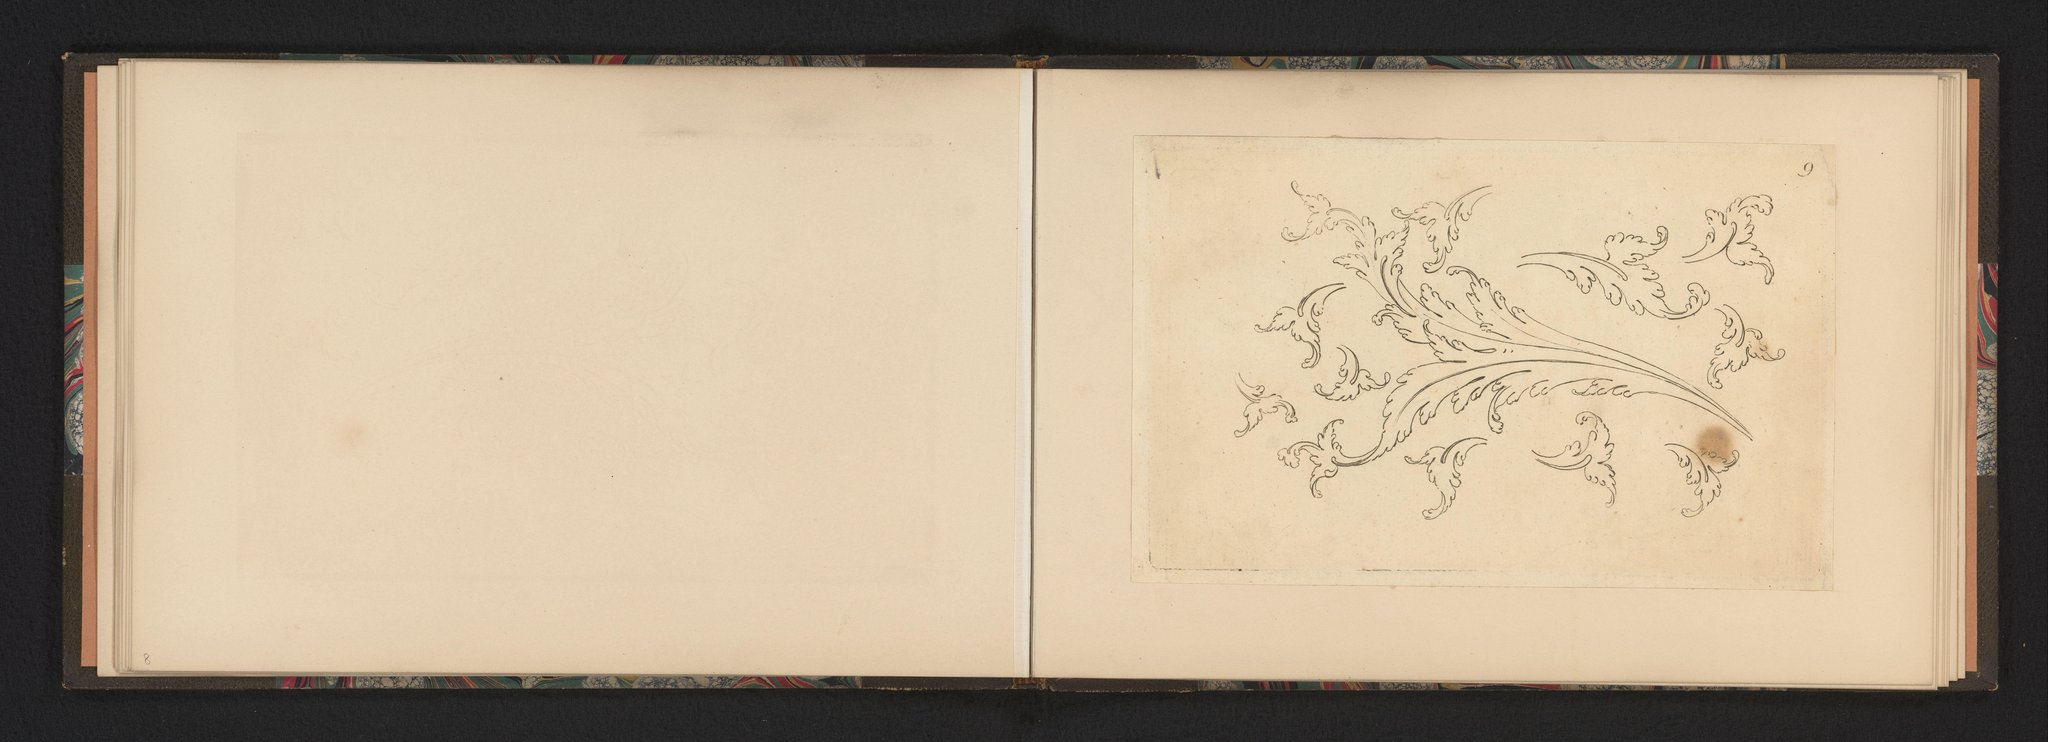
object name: ornament print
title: Ornamentele versiering van bladeren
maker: p. baretti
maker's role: print maker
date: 1766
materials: paper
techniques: engraving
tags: ornaments ~ art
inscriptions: number: ‘9’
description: Ingeplakte prent met ornamentele versiering van bladeren, schematisch weergegeven. Prent maakt deel uit van een album.